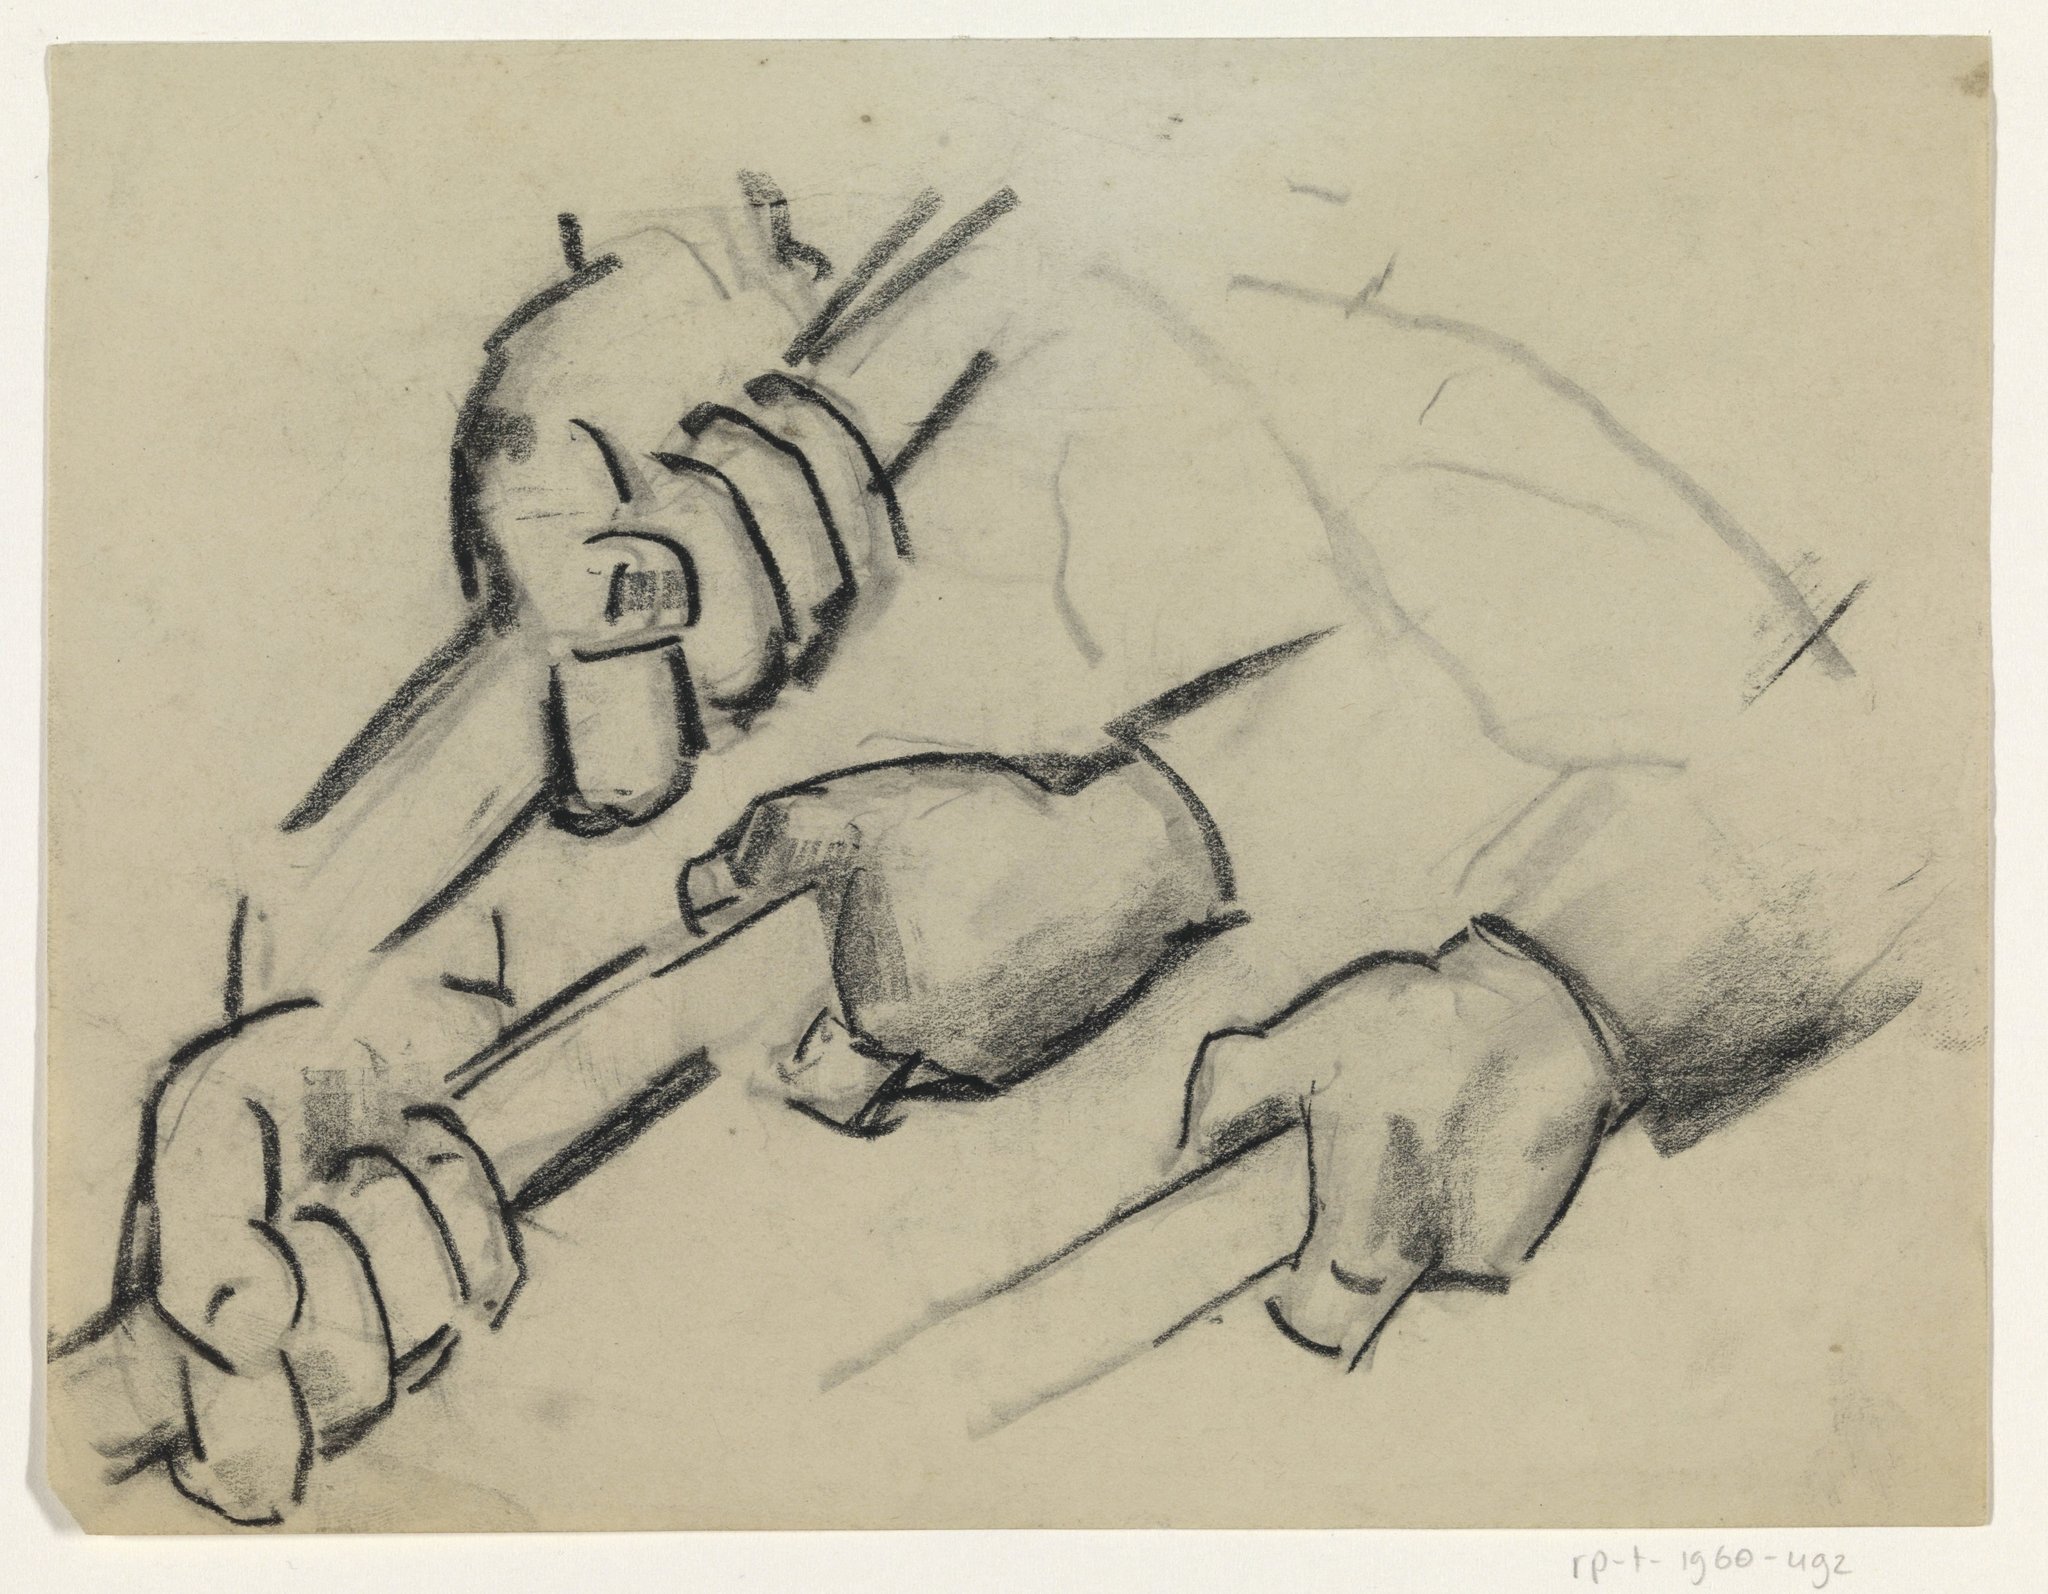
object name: drawing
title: Vier handen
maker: leo gestel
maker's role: draughtsman, print maker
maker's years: 1881-1941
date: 1891-1941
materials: chalk, paper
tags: hand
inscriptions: collector's mark: Lugt 2228